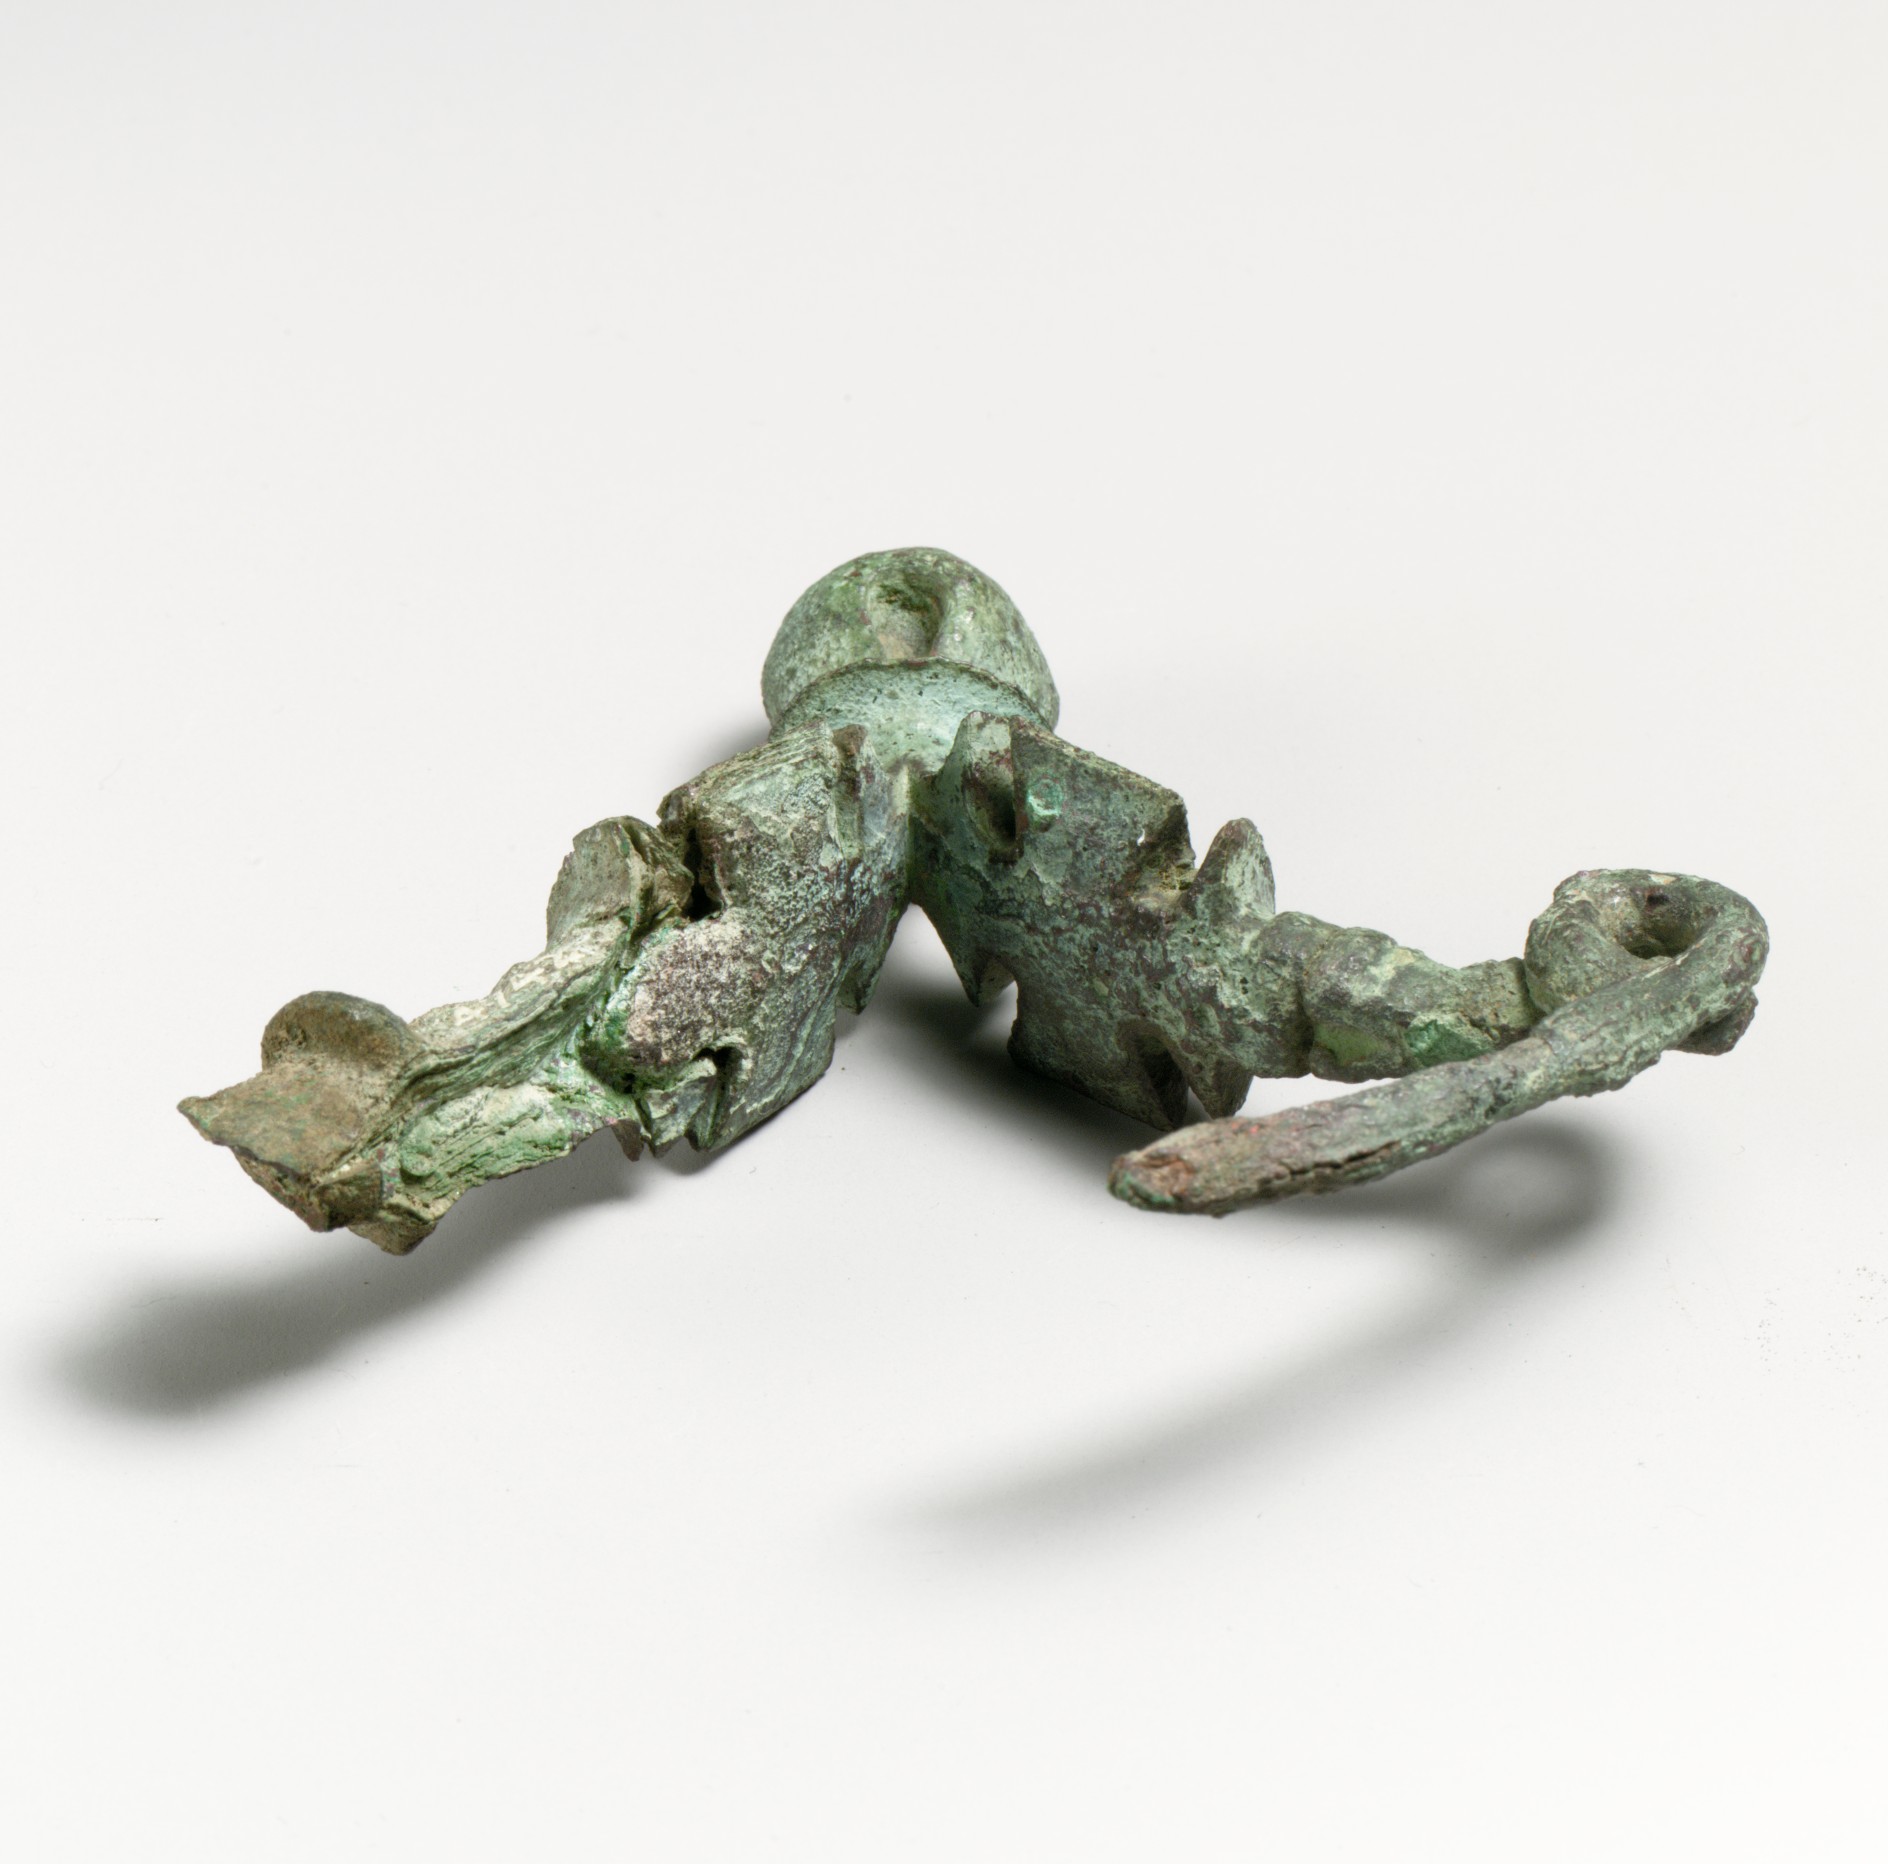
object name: fibula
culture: greek, cypriot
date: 7000-30 BCE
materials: bronze